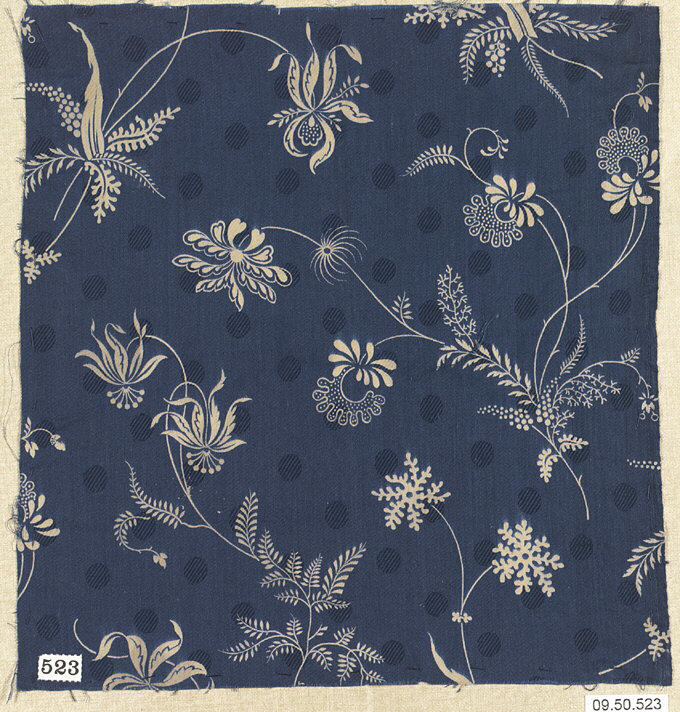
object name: piece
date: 1801-1900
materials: cotton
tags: leaves